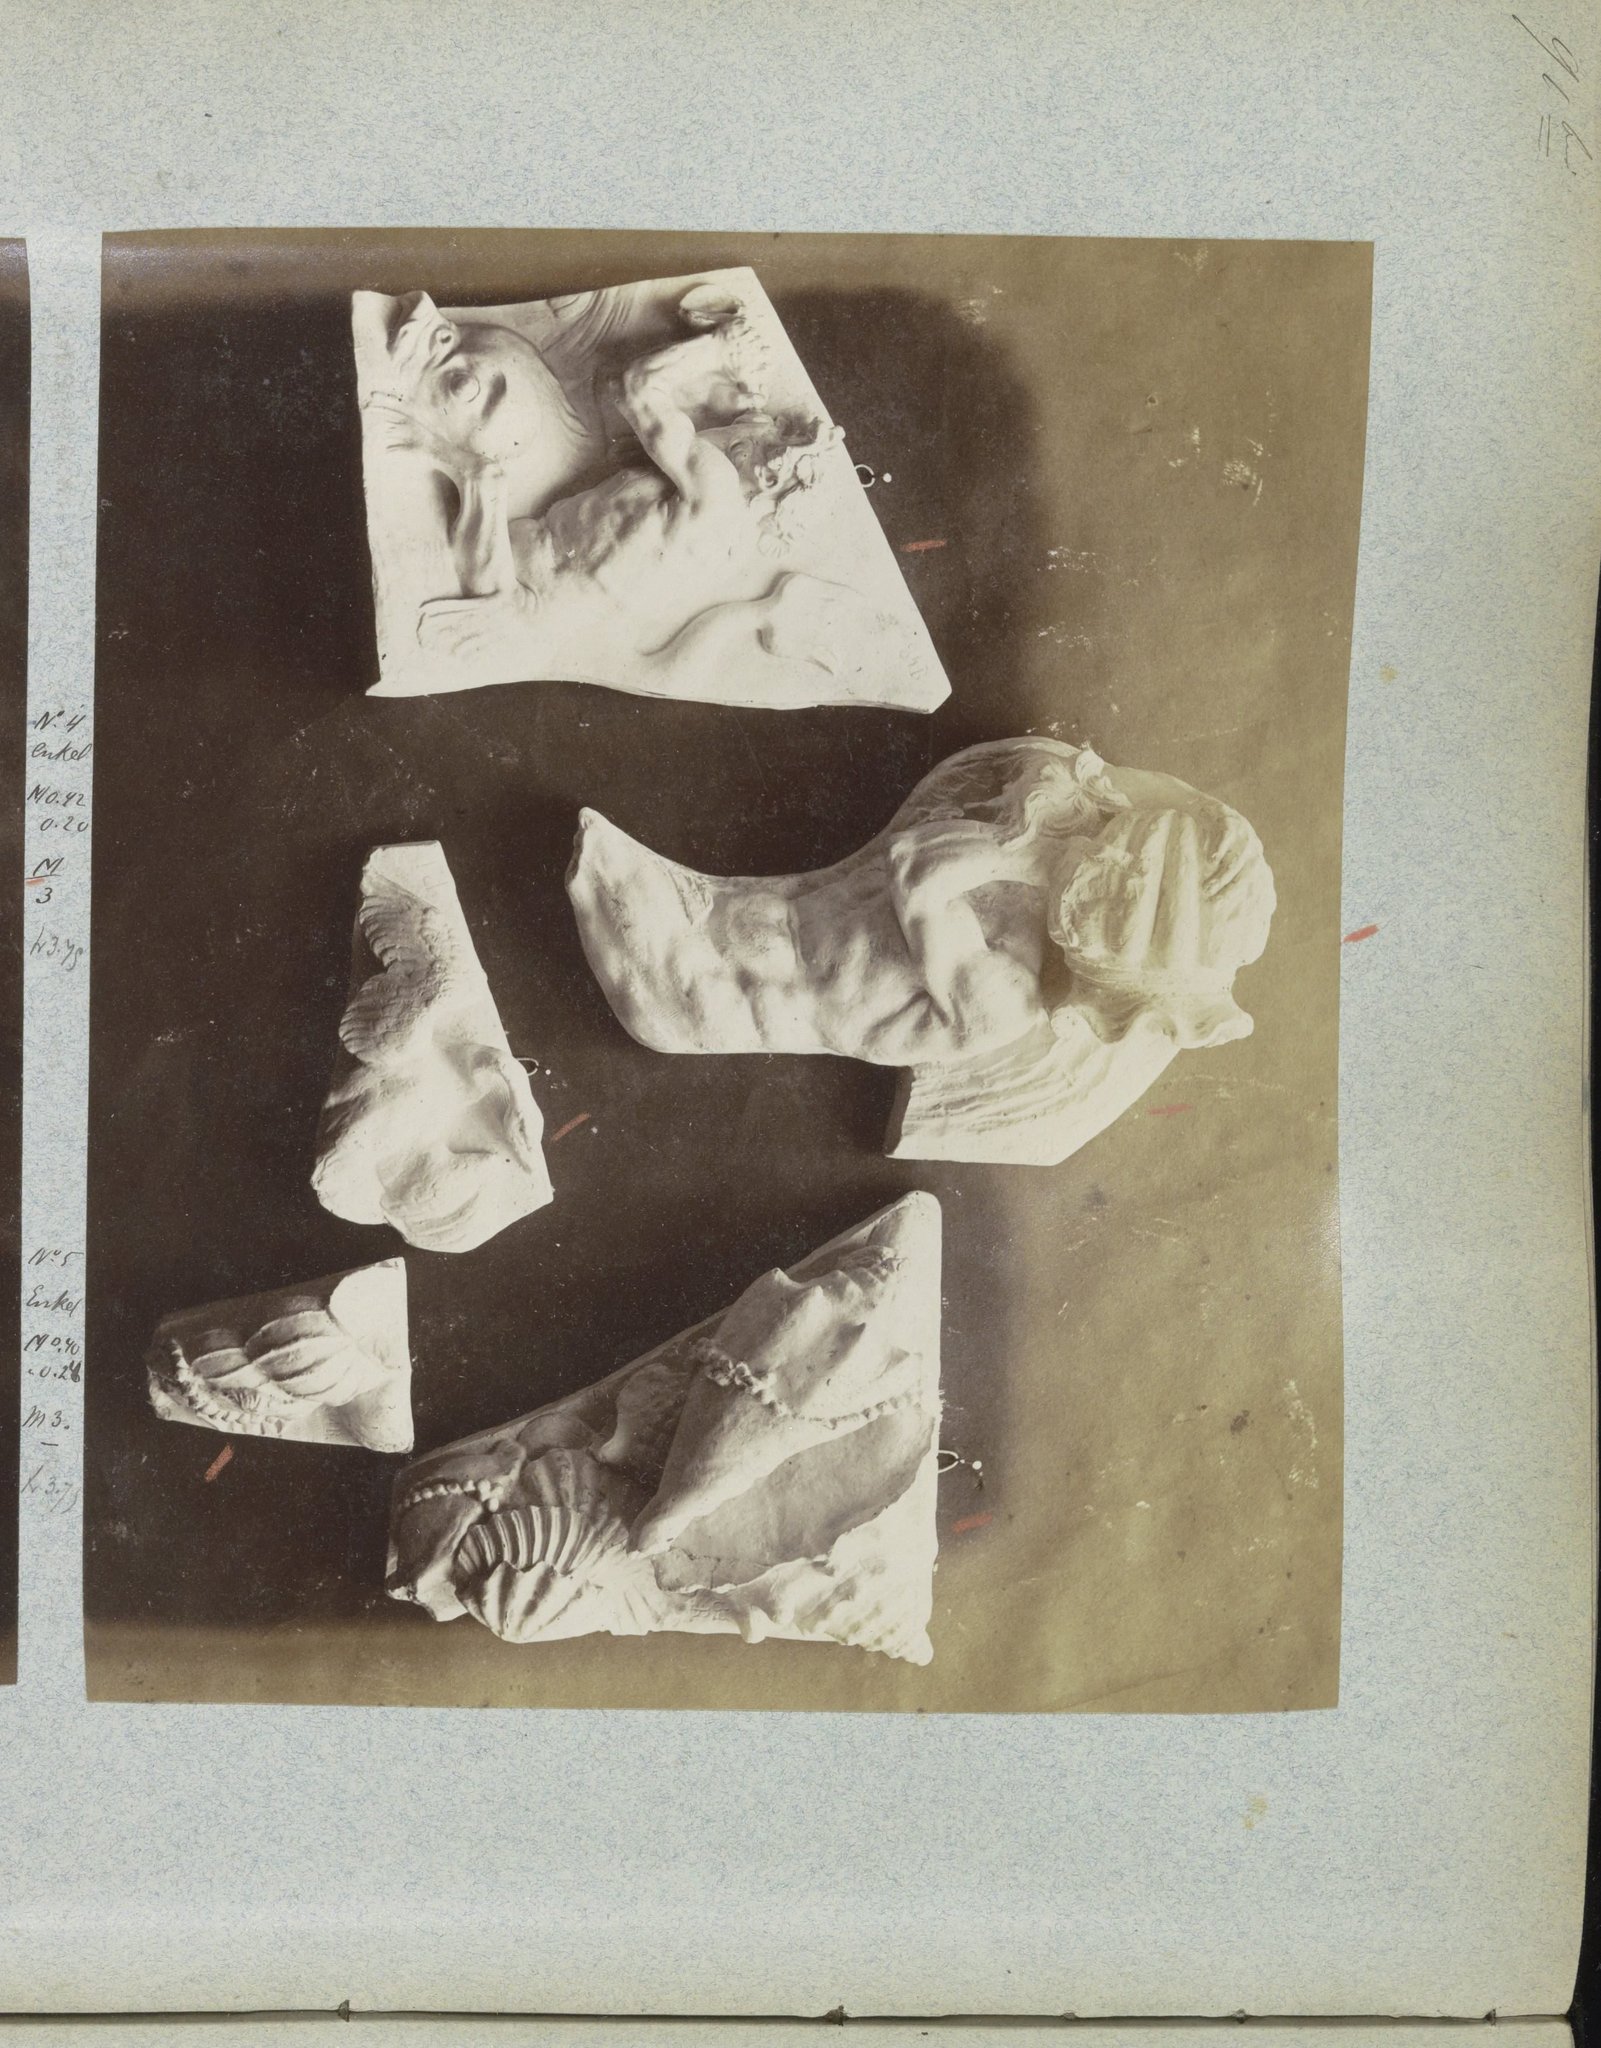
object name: photograph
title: Vijf gipsen afgietsels van beeldhouwwerken van het Raadhuis Amsterdam, door Artus Quellinus I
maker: Anonymous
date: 1875-1900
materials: paper, photographic support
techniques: albumen print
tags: royal palace of amsterdam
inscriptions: annotation